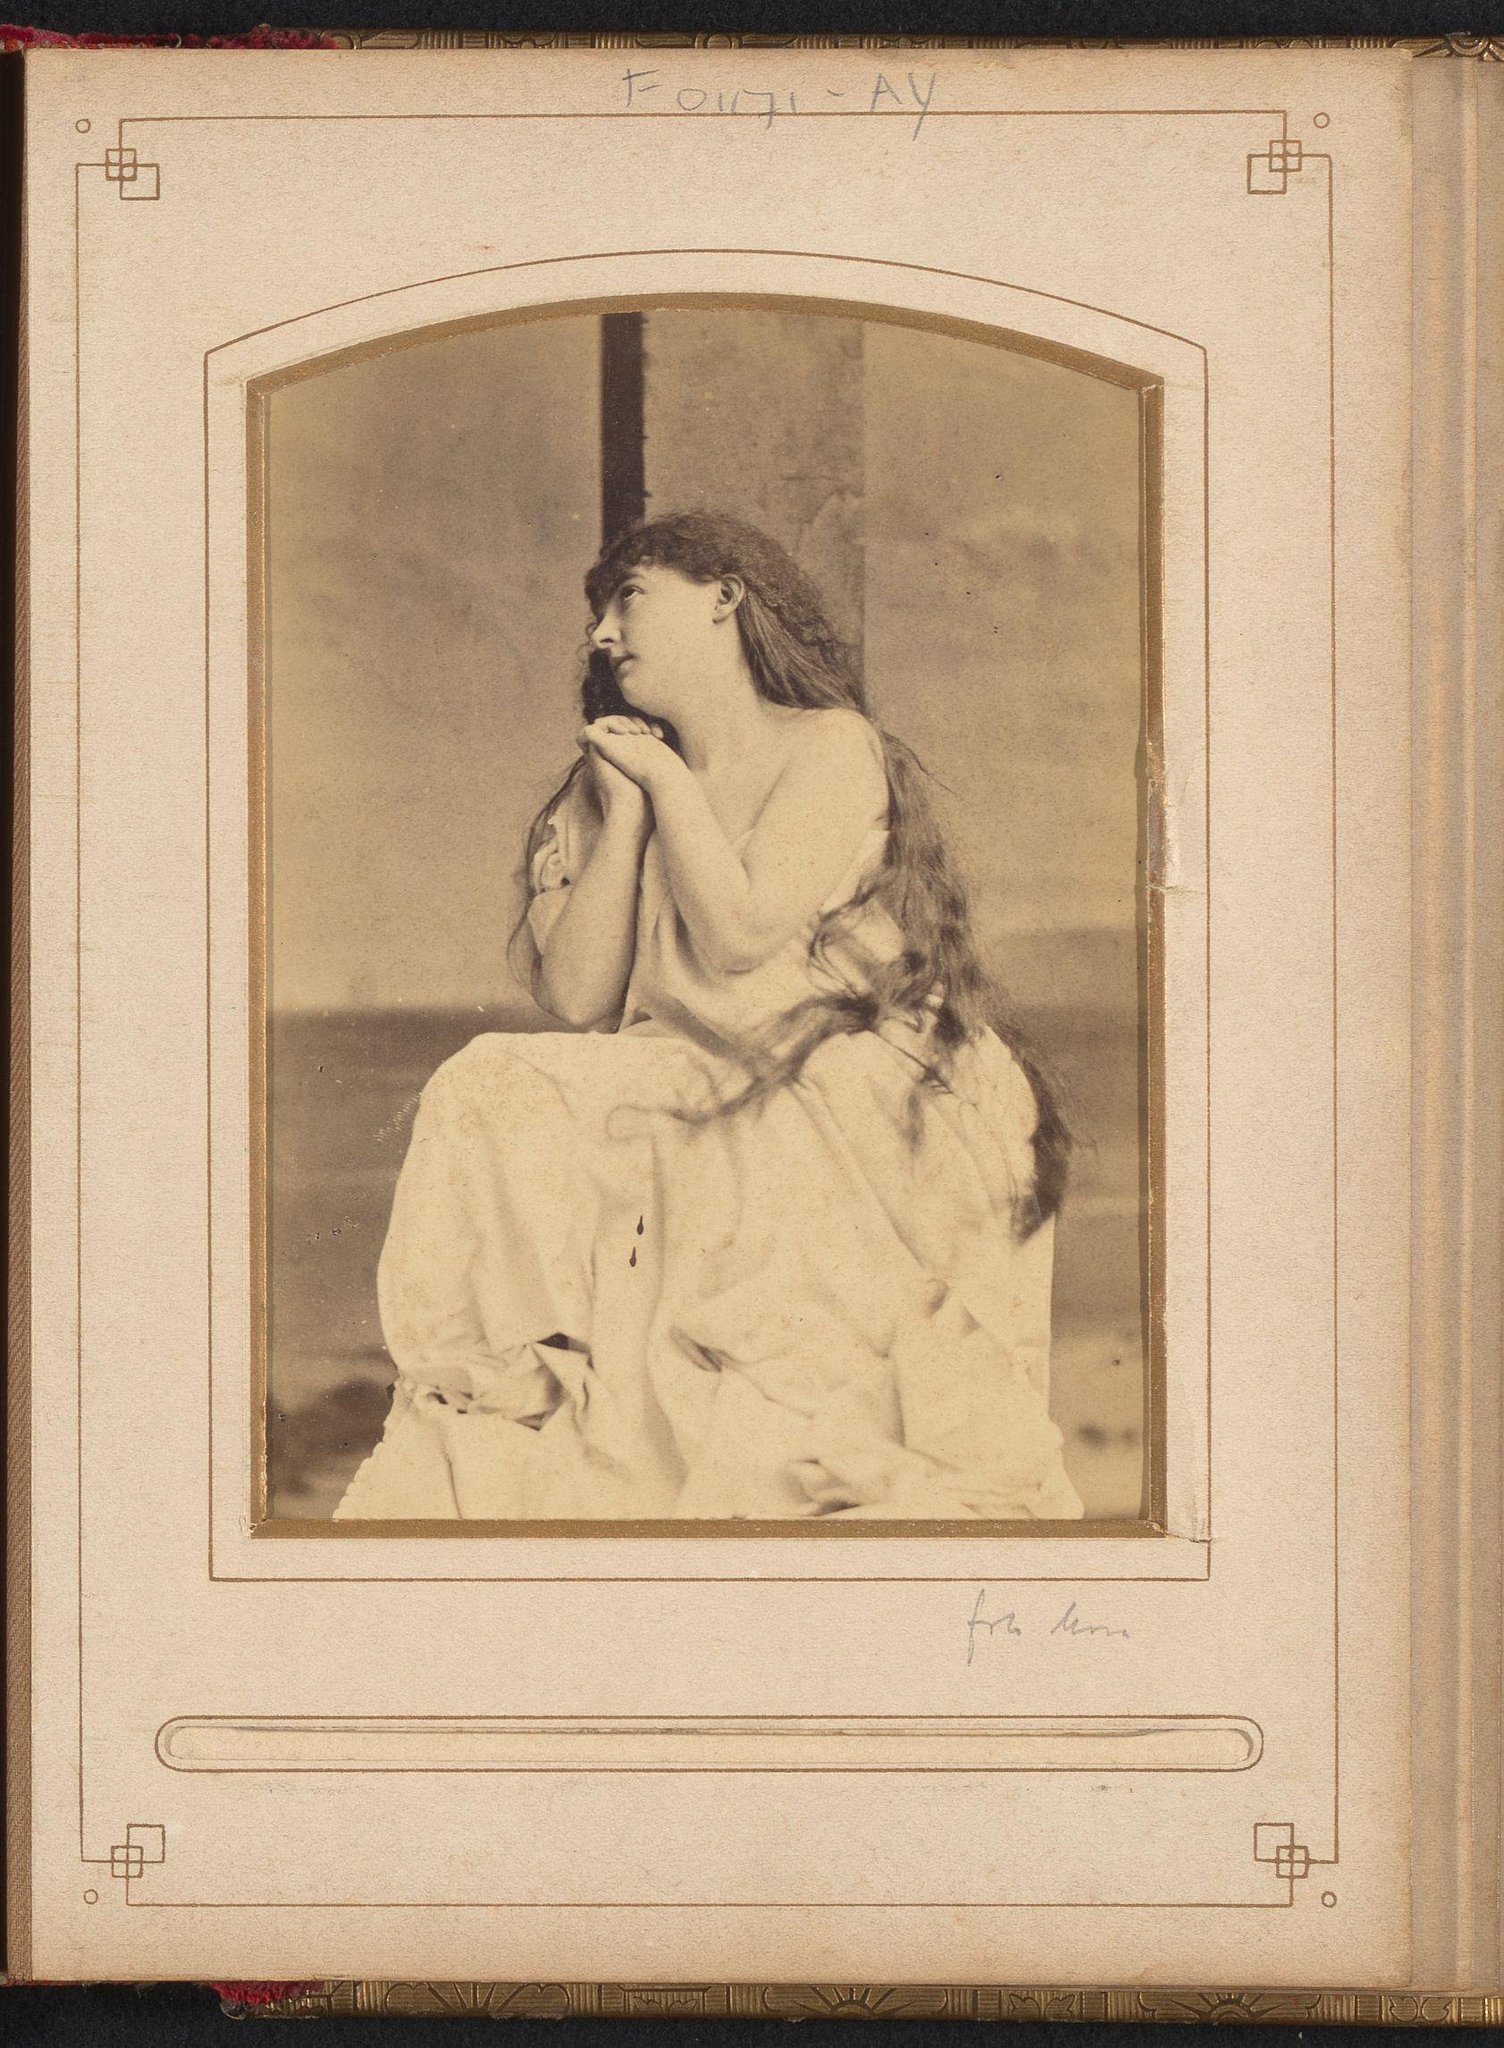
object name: photograph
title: Portret van een actrice, afgebeeld als Maria Magdalena aan de voet van het kruis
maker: josé maria mora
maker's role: fotograaf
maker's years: 1849-1926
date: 1870-1900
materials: cardboard, photographic support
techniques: albumen print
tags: adult woman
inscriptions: number: ‘4599/1.15’, name: ‘Mora 707 Broadway, N.Y.’